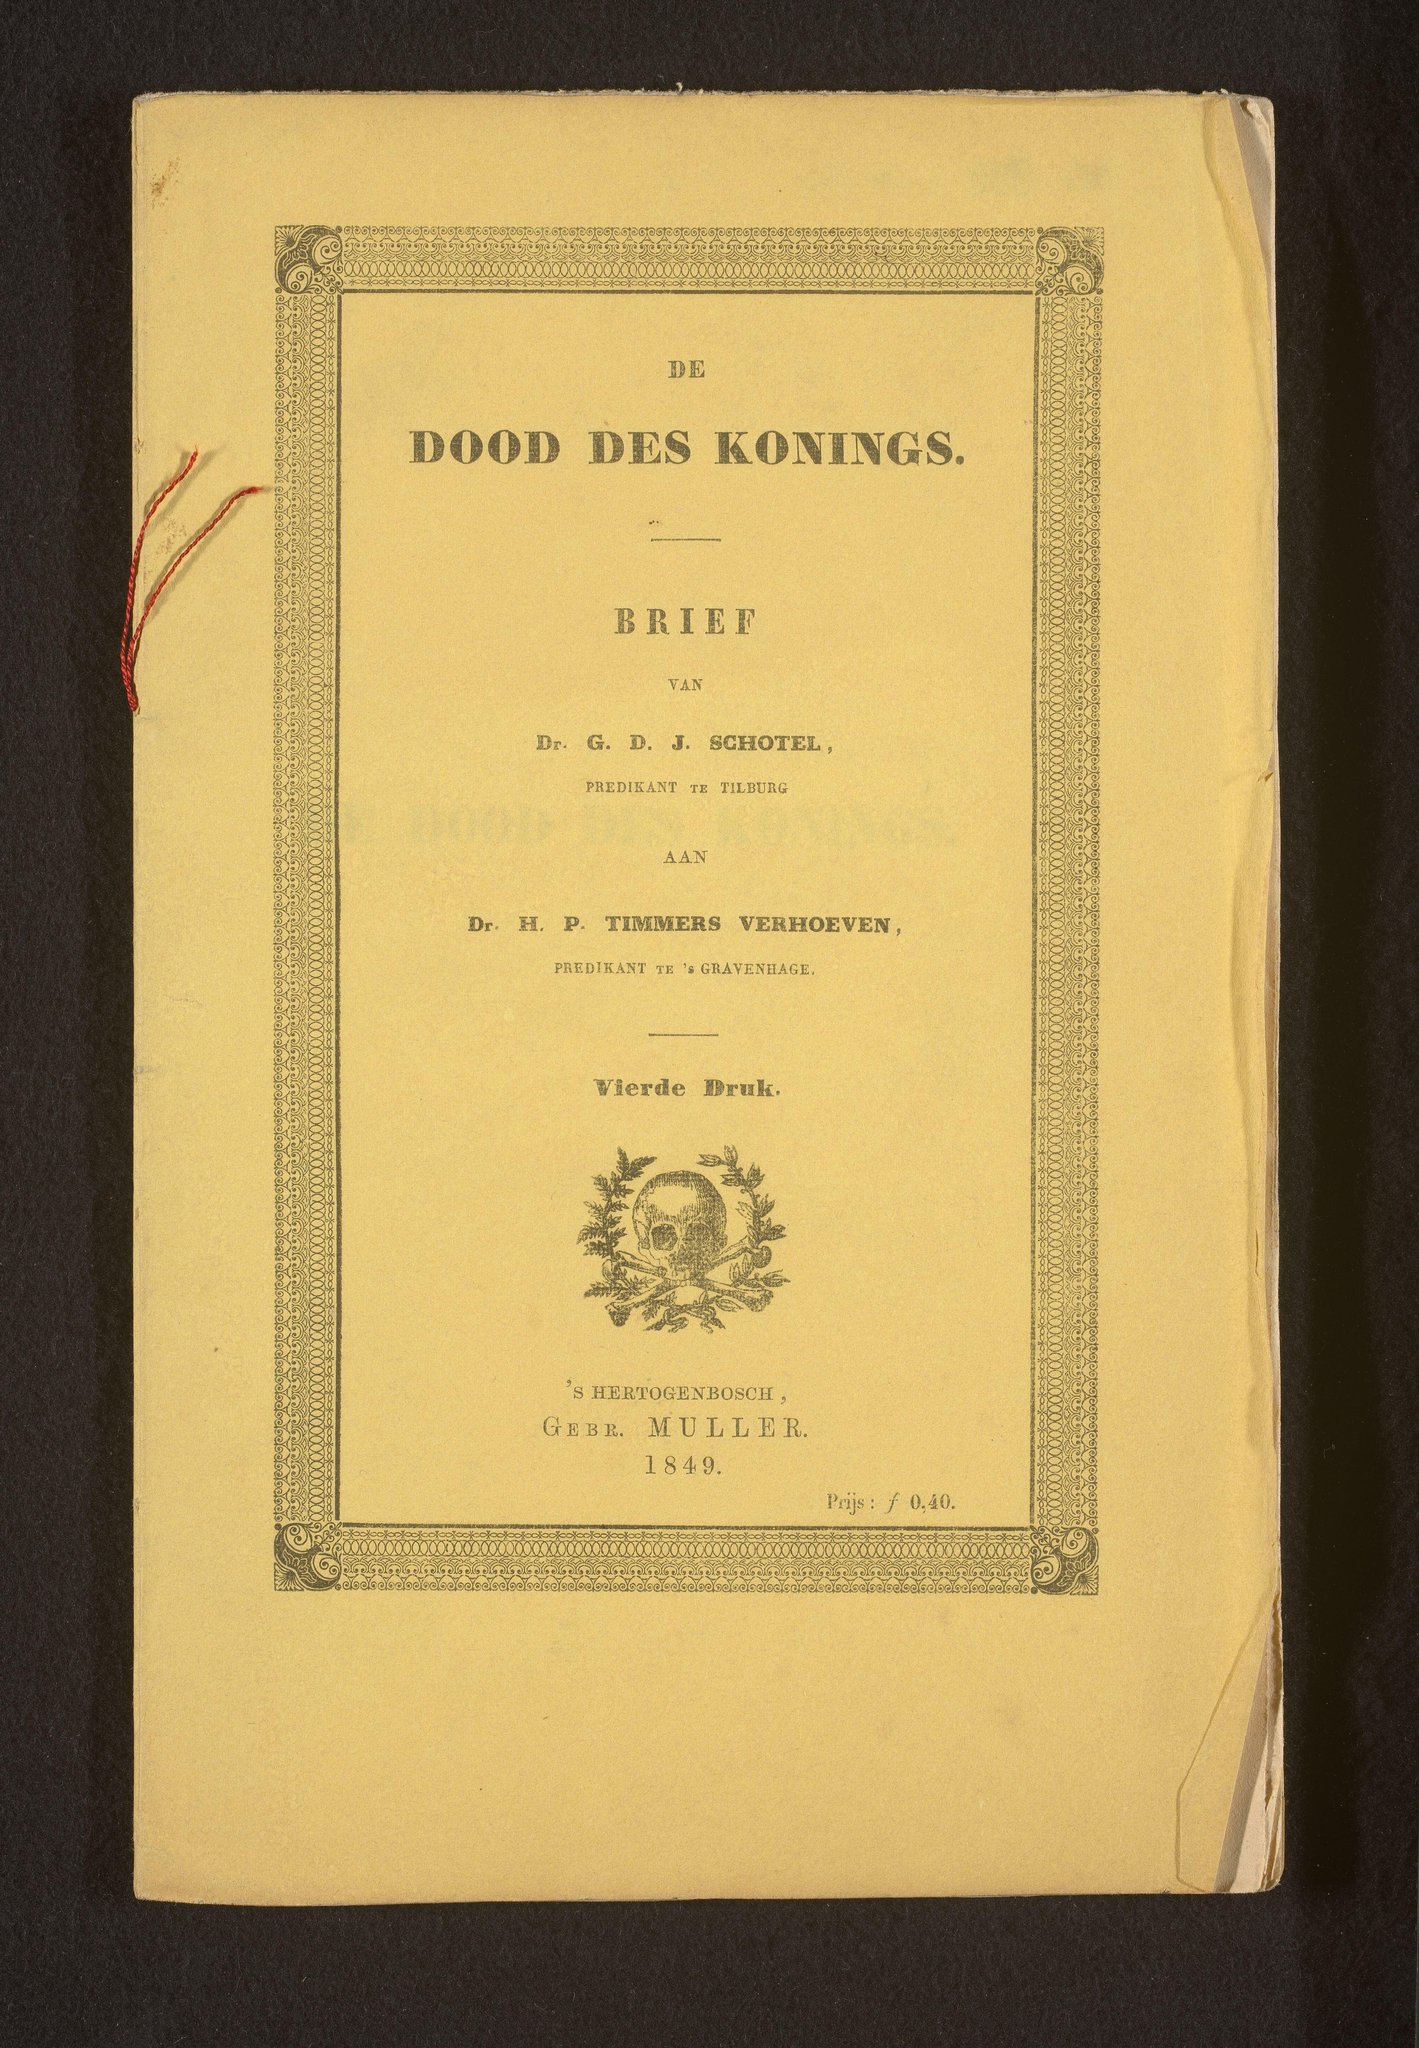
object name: brochure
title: De Dood des Konings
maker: gilles dionysius jacobus schotel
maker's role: schrijver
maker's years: 1807-1892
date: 1849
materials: paper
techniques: brocade, printing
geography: den bosch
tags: the hague, william ii of the netherlands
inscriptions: date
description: 31 genummerde pp in gele omslag. Gedateerd; titelp.: 1849.